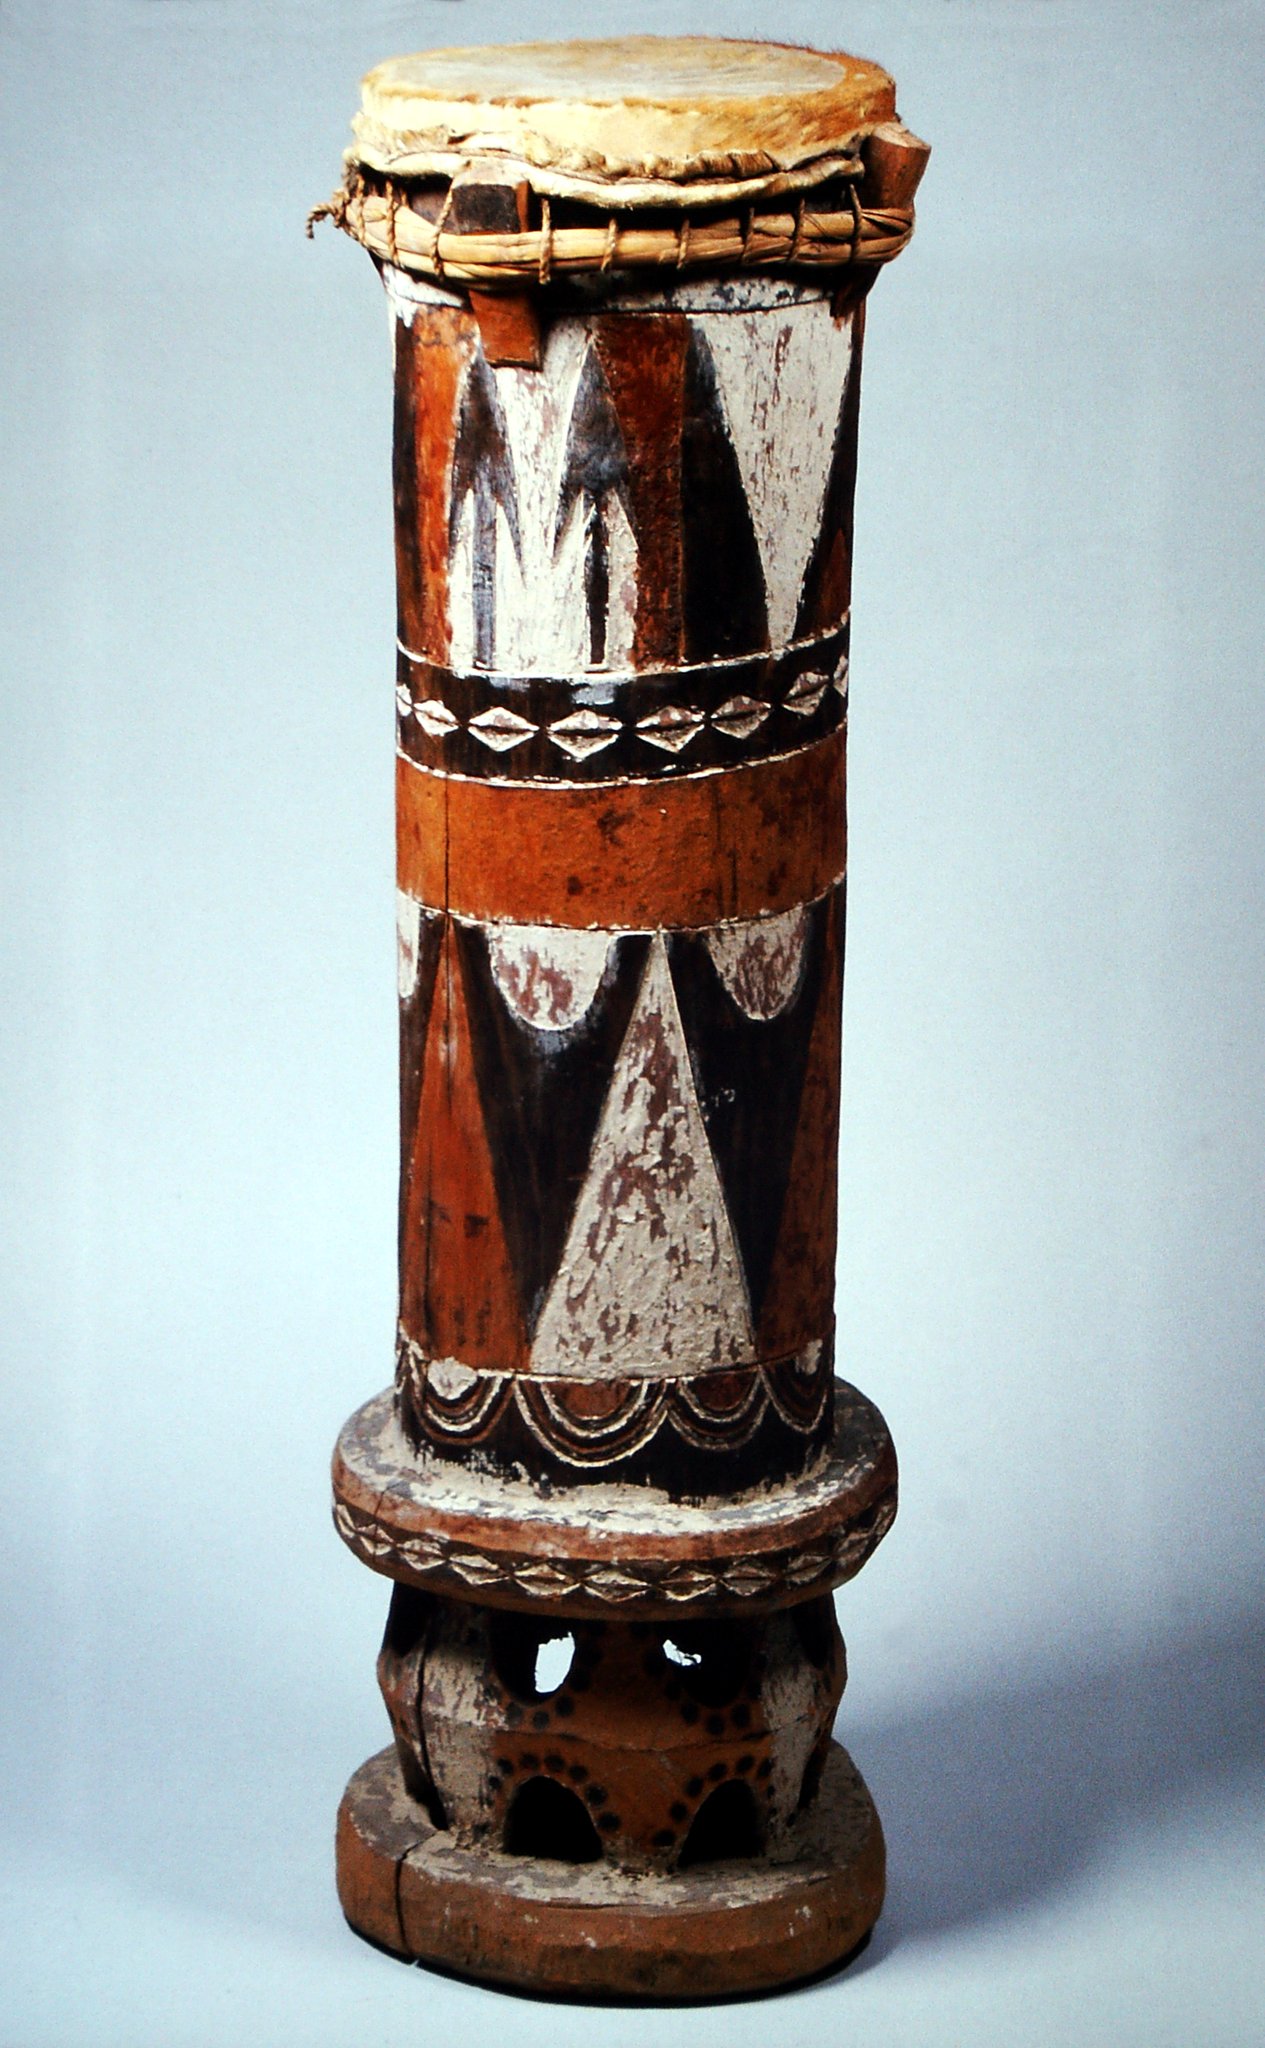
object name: mbejn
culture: fang people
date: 1801-1900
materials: wood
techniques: polychrome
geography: gabon